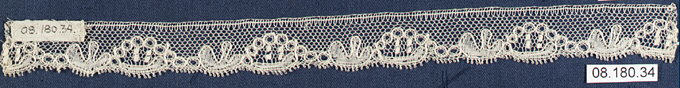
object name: fragment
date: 1801-1900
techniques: lace